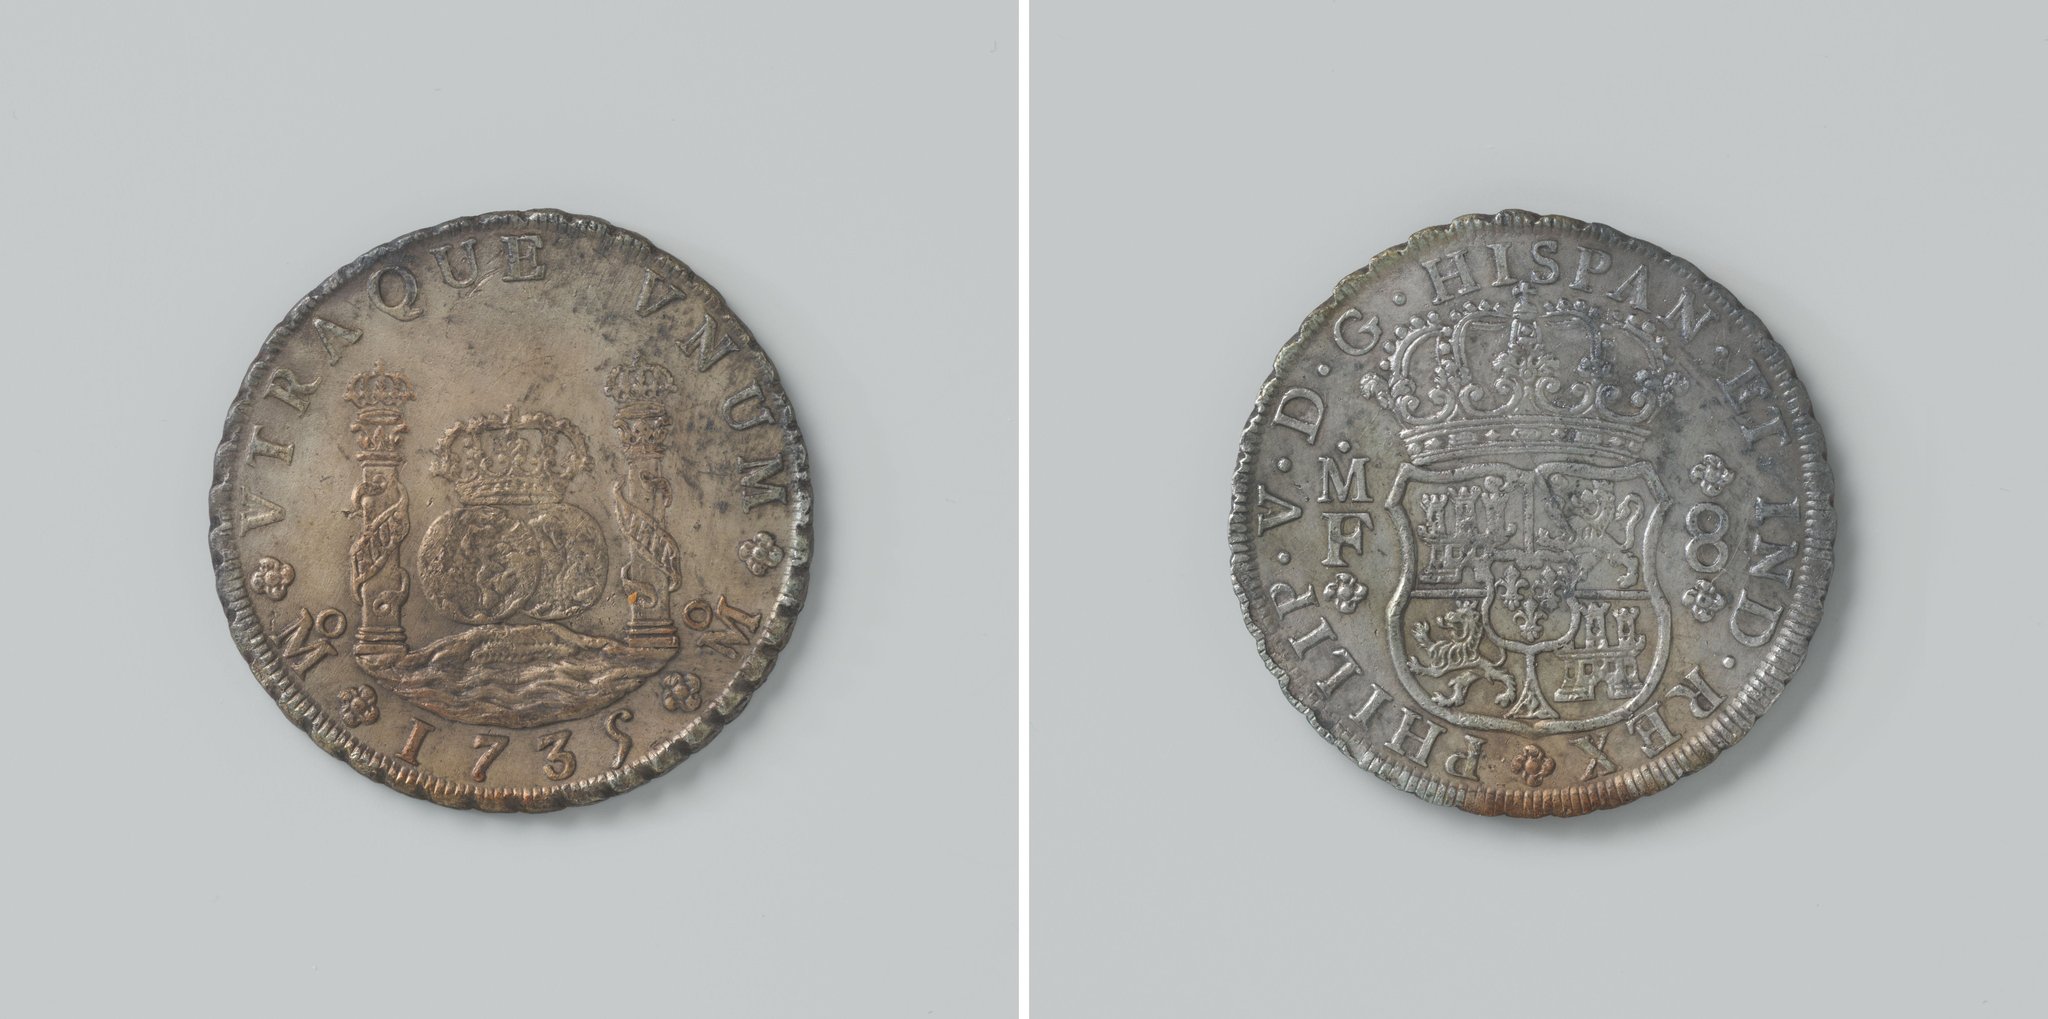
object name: coin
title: acht reaal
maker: Anonymous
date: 1735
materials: silver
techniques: striking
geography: mexico city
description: Spaans-Amerika, acht reaal uit VOC-wrak Hollandia 1742.